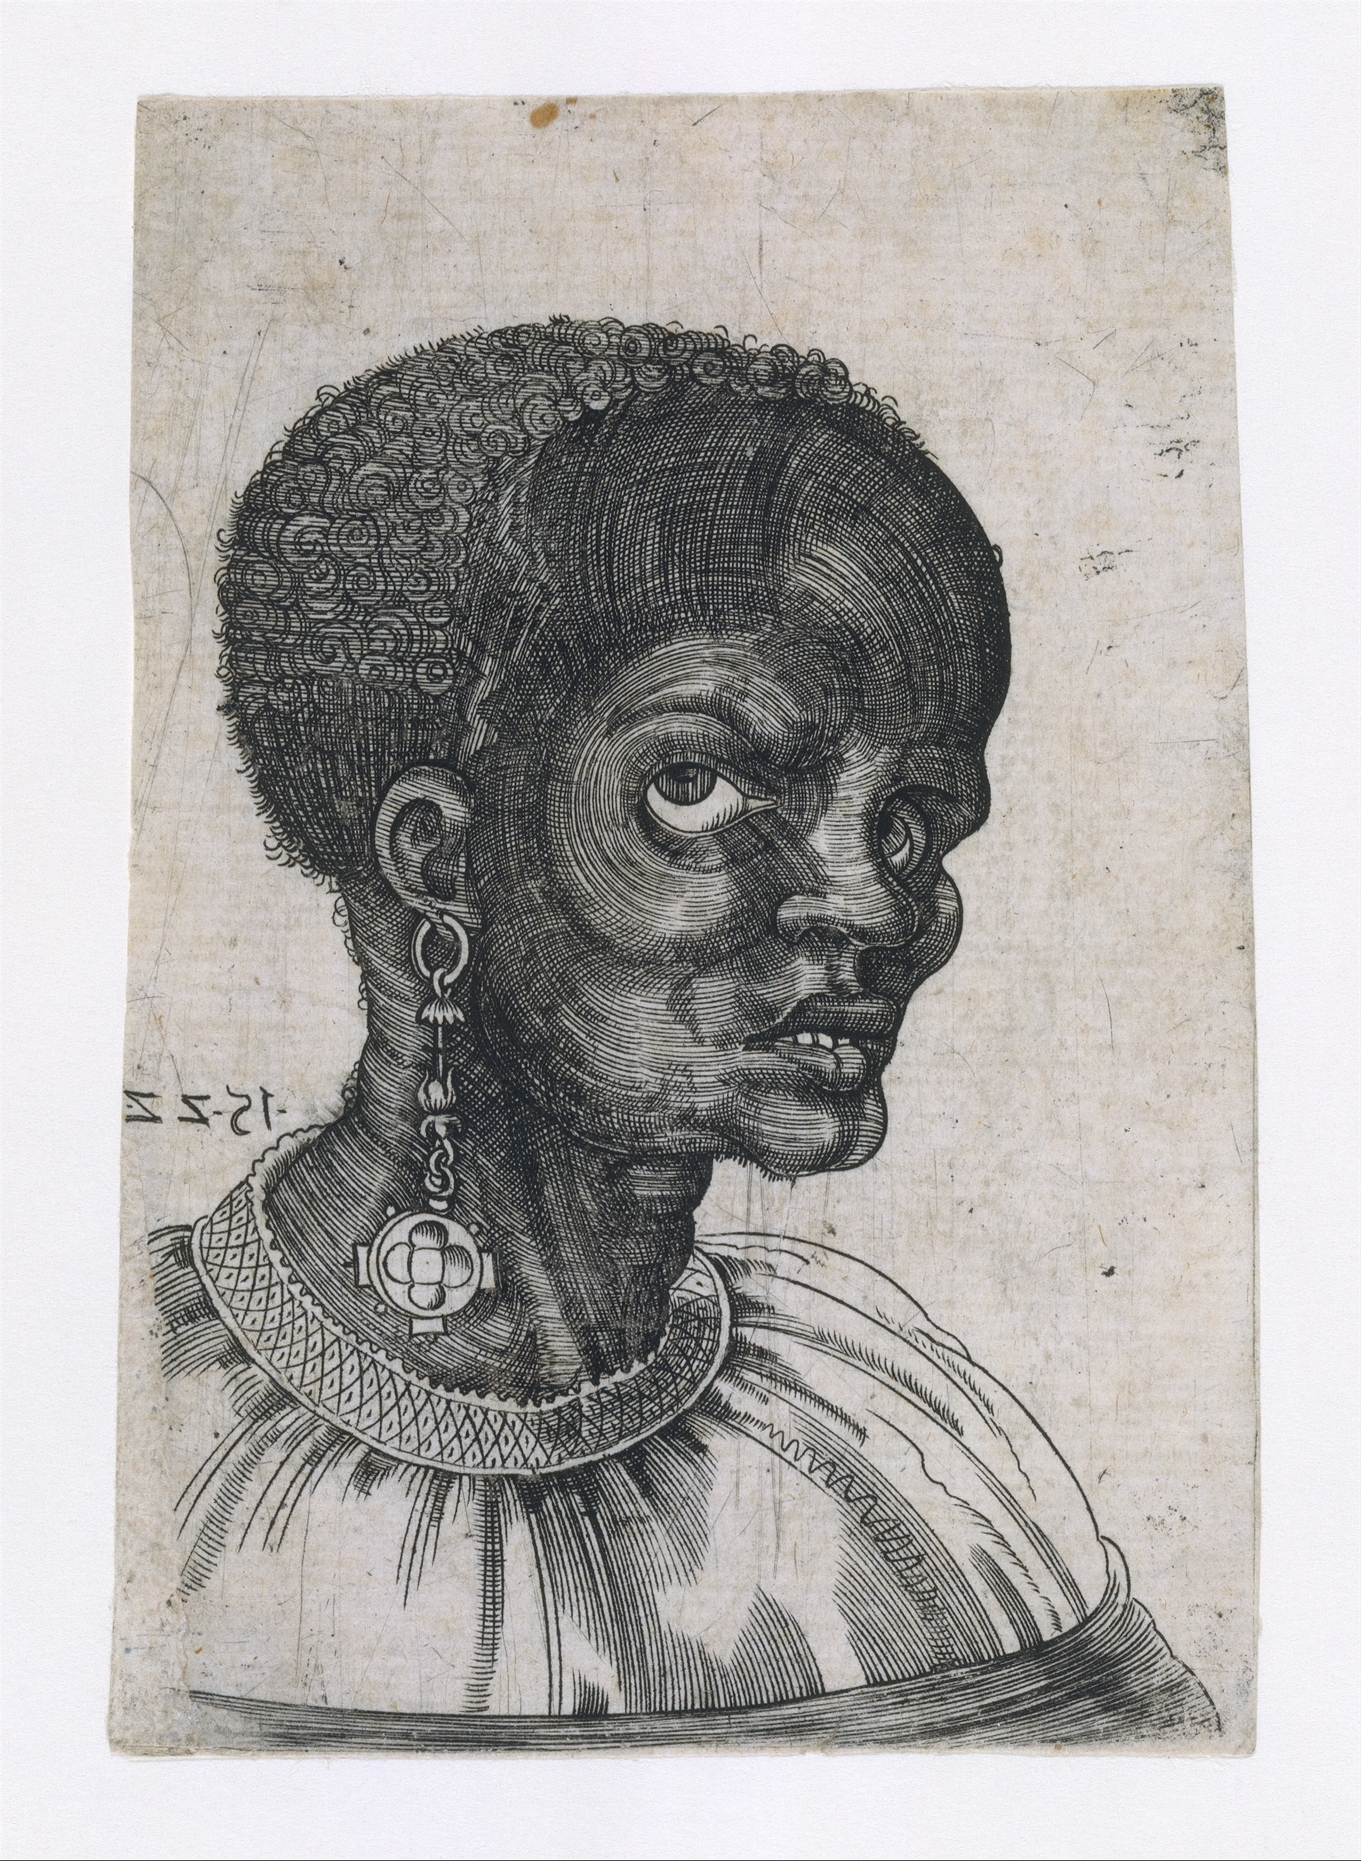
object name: print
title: Head of a Man in Three-Quarter Profile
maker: frans crabbe van espleghem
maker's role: artist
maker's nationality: netherlandish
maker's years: 1480-1553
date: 1522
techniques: engraving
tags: men,portraits